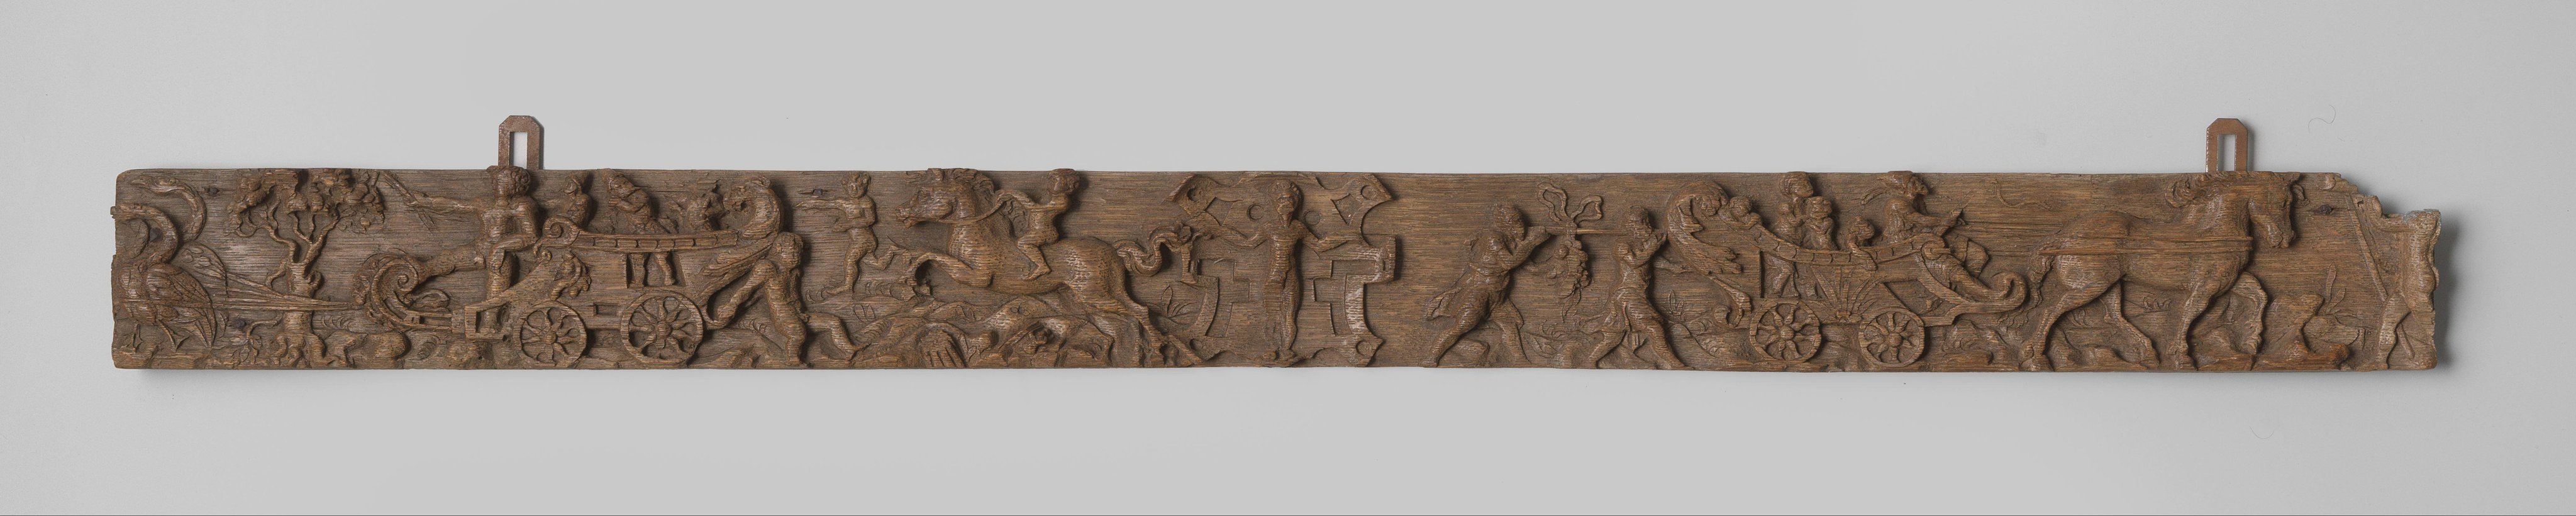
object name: panel surface component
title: Onderdeel van een wellicht een kerkmeubel, kuip van een preekstoel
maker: Anonymous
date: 1550-1600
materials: wood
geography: northern netherlands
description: Paneel van eikenhout, vermoedelijk afkomstig van een meubel (preekstoelkuip), versierd met een gestoken reliëf. In het midden staat voor een rolwerk-cartouche een mannenfiguur, links een galopperend paard met een kind en een wagen bespannen met zwanen, rechts mannen met een druiventros en een wagen met een paard bespannen. De groepen bewegen zich van het midden af; op de wagens bevinden zich verschillende figuren.